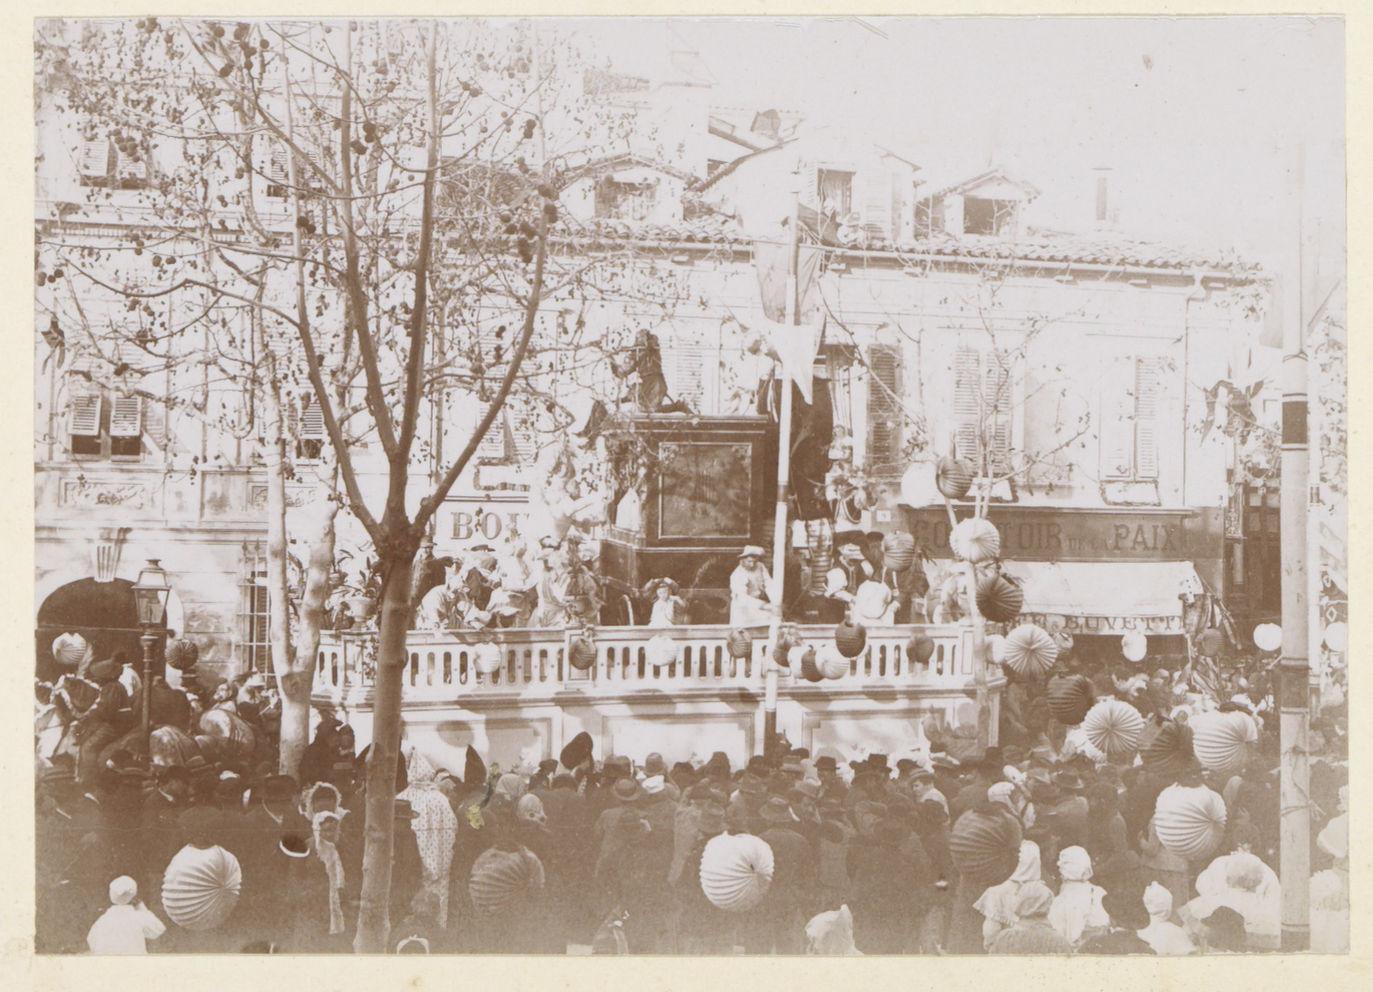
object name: photograph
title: Optocht met praalwagen en verklede mensen, mogelijk tijdens het carnaval in Nice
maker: Anonymous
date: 1900-1910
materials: paper, photographic support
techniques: daylight paper print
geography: nice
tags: crowd, mob, carnival, shrovetide (non-liturgical celebration), exterior ~ representation of a building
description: Onderdeel van Fotoalbum van een Franse amateurfotograaf met opnames van een familie, distilleerderij Delizy & Doistau Fils, het leger en bezienswaardigheden in Frankrijk.